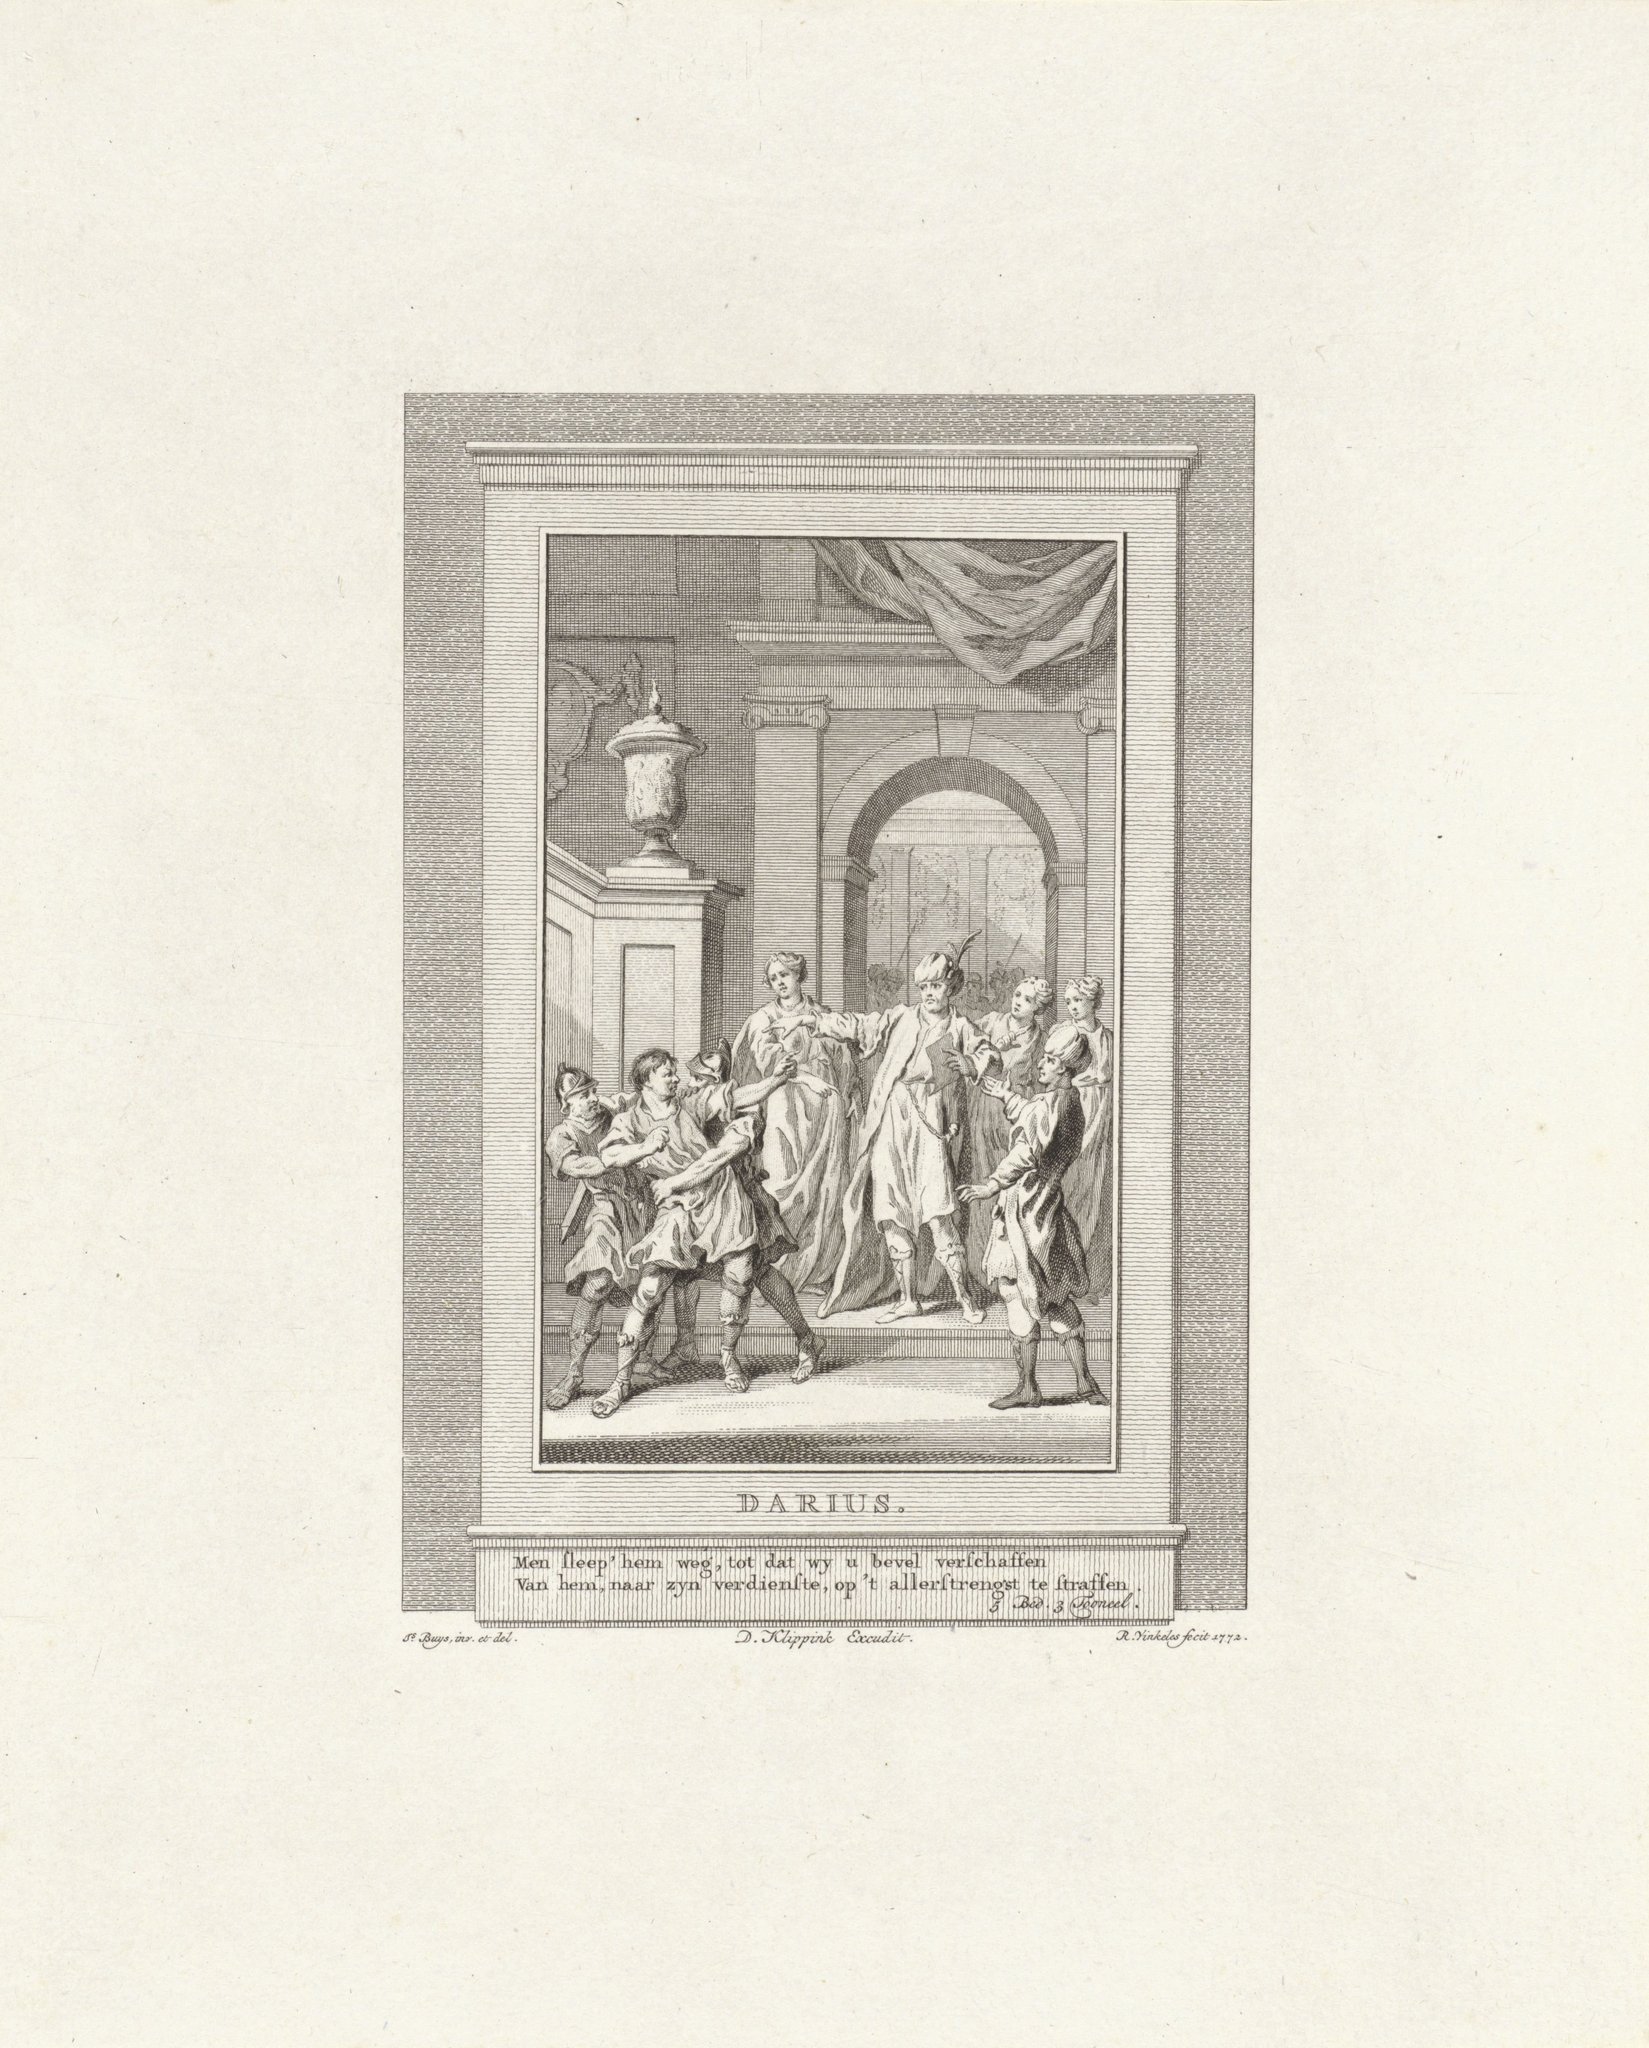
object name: print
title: Darius.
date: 1772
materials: paper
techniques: engraving, etching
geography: amsterdam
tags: the soldier; the soldier's life, ruler, sovereign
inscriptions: collector's mark: Lugt 240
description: Mogelijk ook gebruikt als illustratie voor: Feitama, Sybrand. Darius: treurspel. Amsterdam: Izaak Duin, 1757.